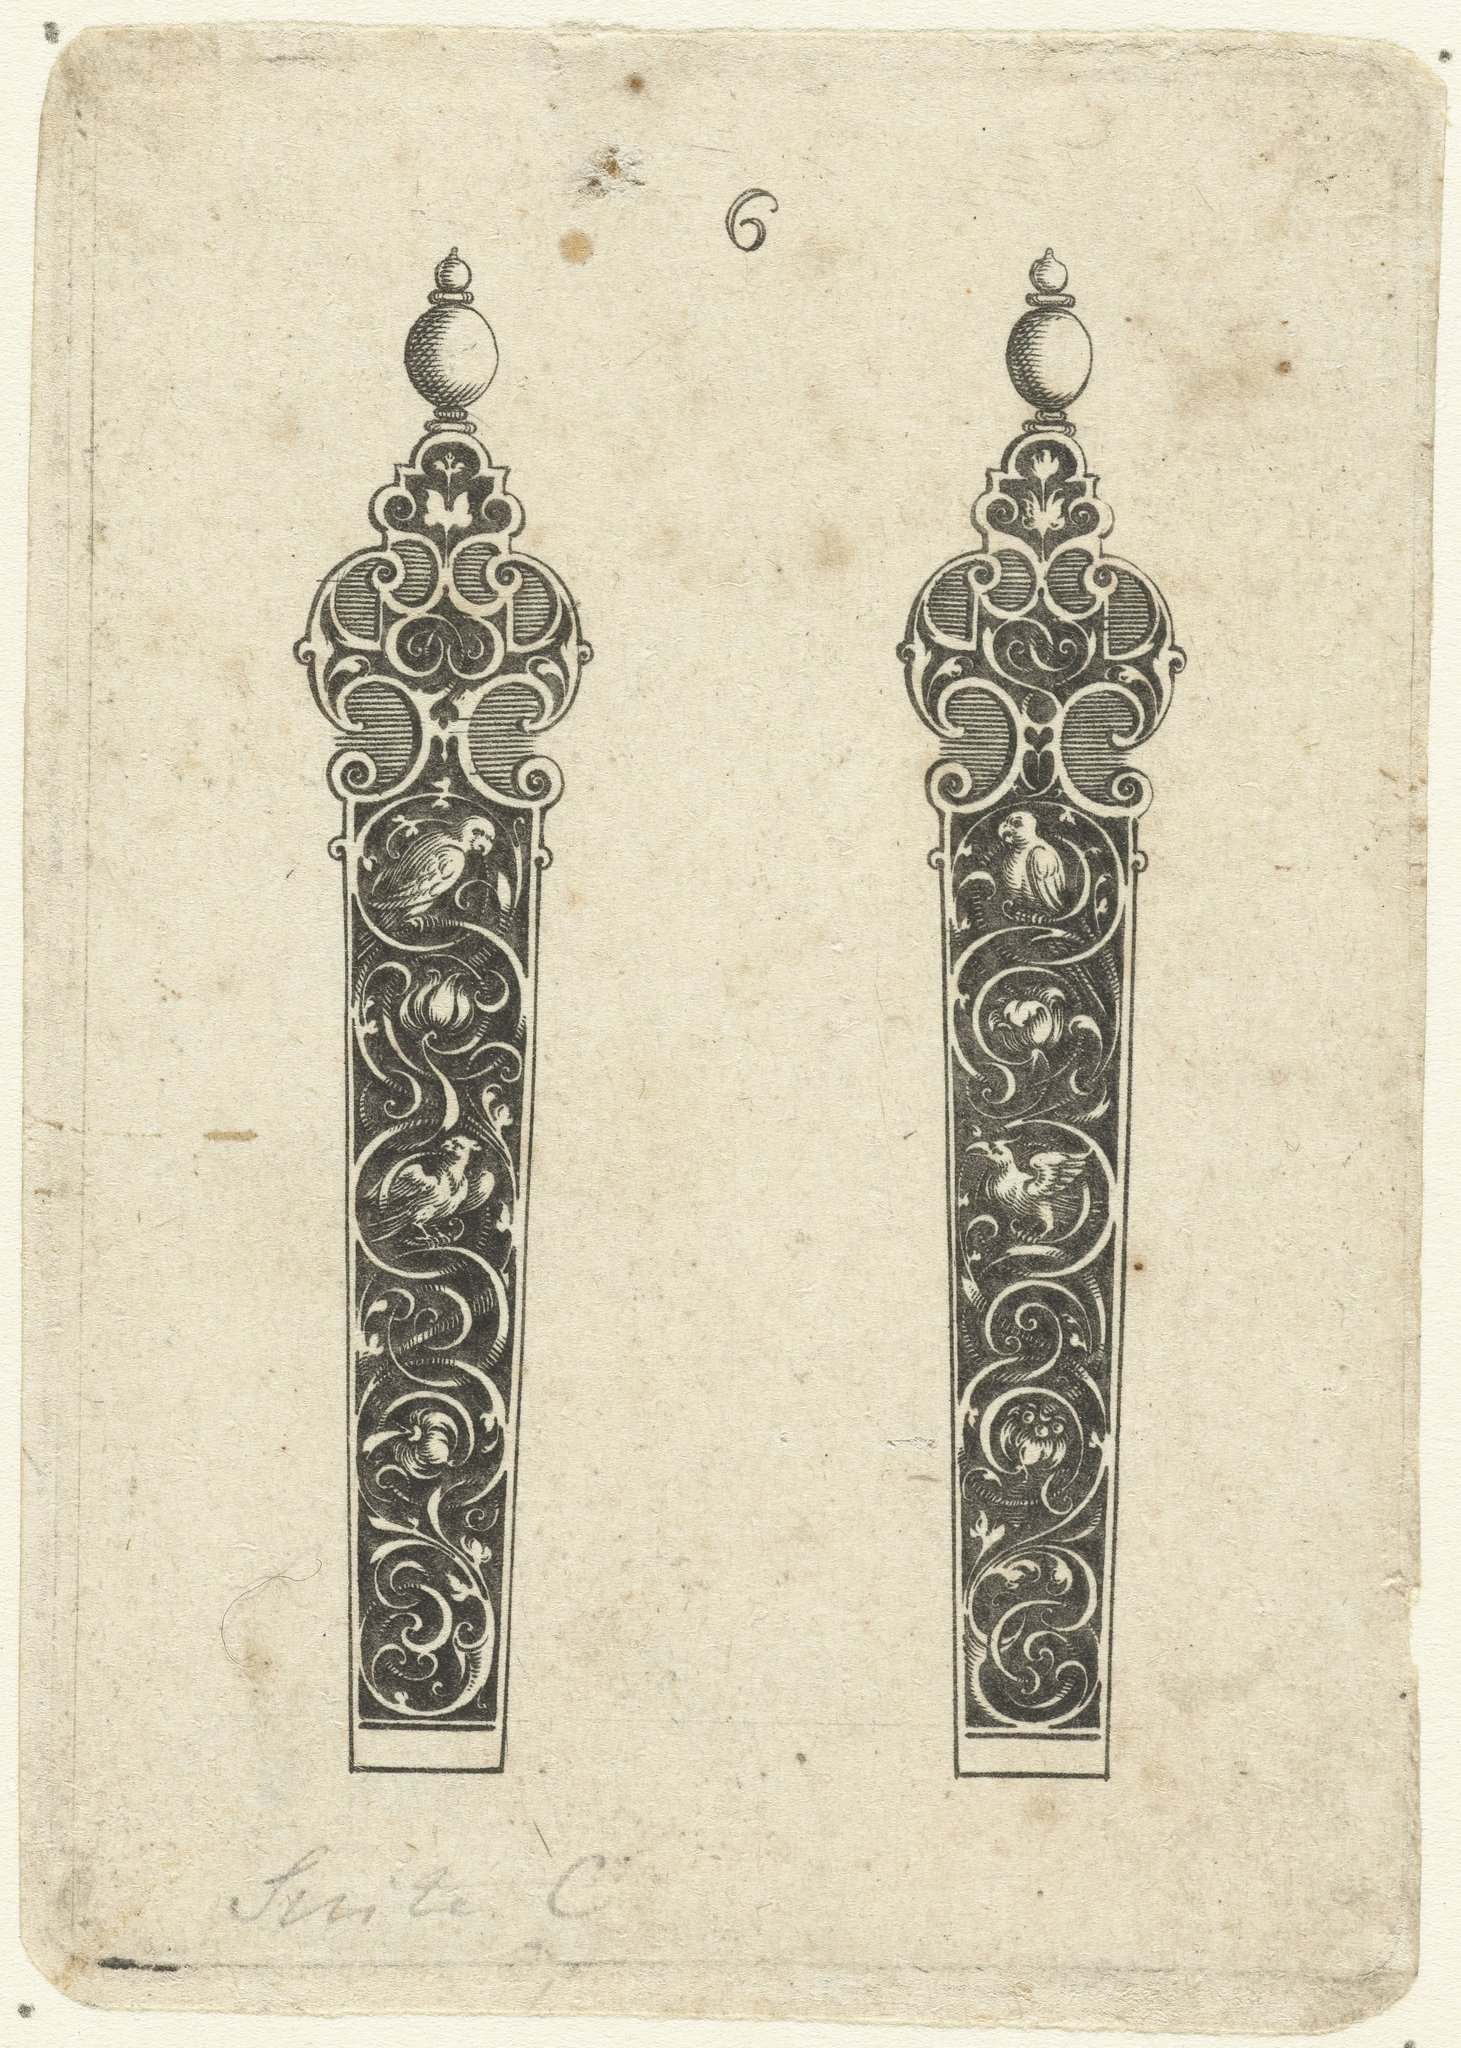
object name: print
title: Messenheften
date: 1597-1656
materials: paper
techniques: etching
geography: amsterdam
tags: birds, table-knife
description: Op elk blad uit deze serie staan twee symmetrische messenheften met bovenaan een kraal. De heften zijn versierd met ranken waartussen zich twee vogels bevinden.